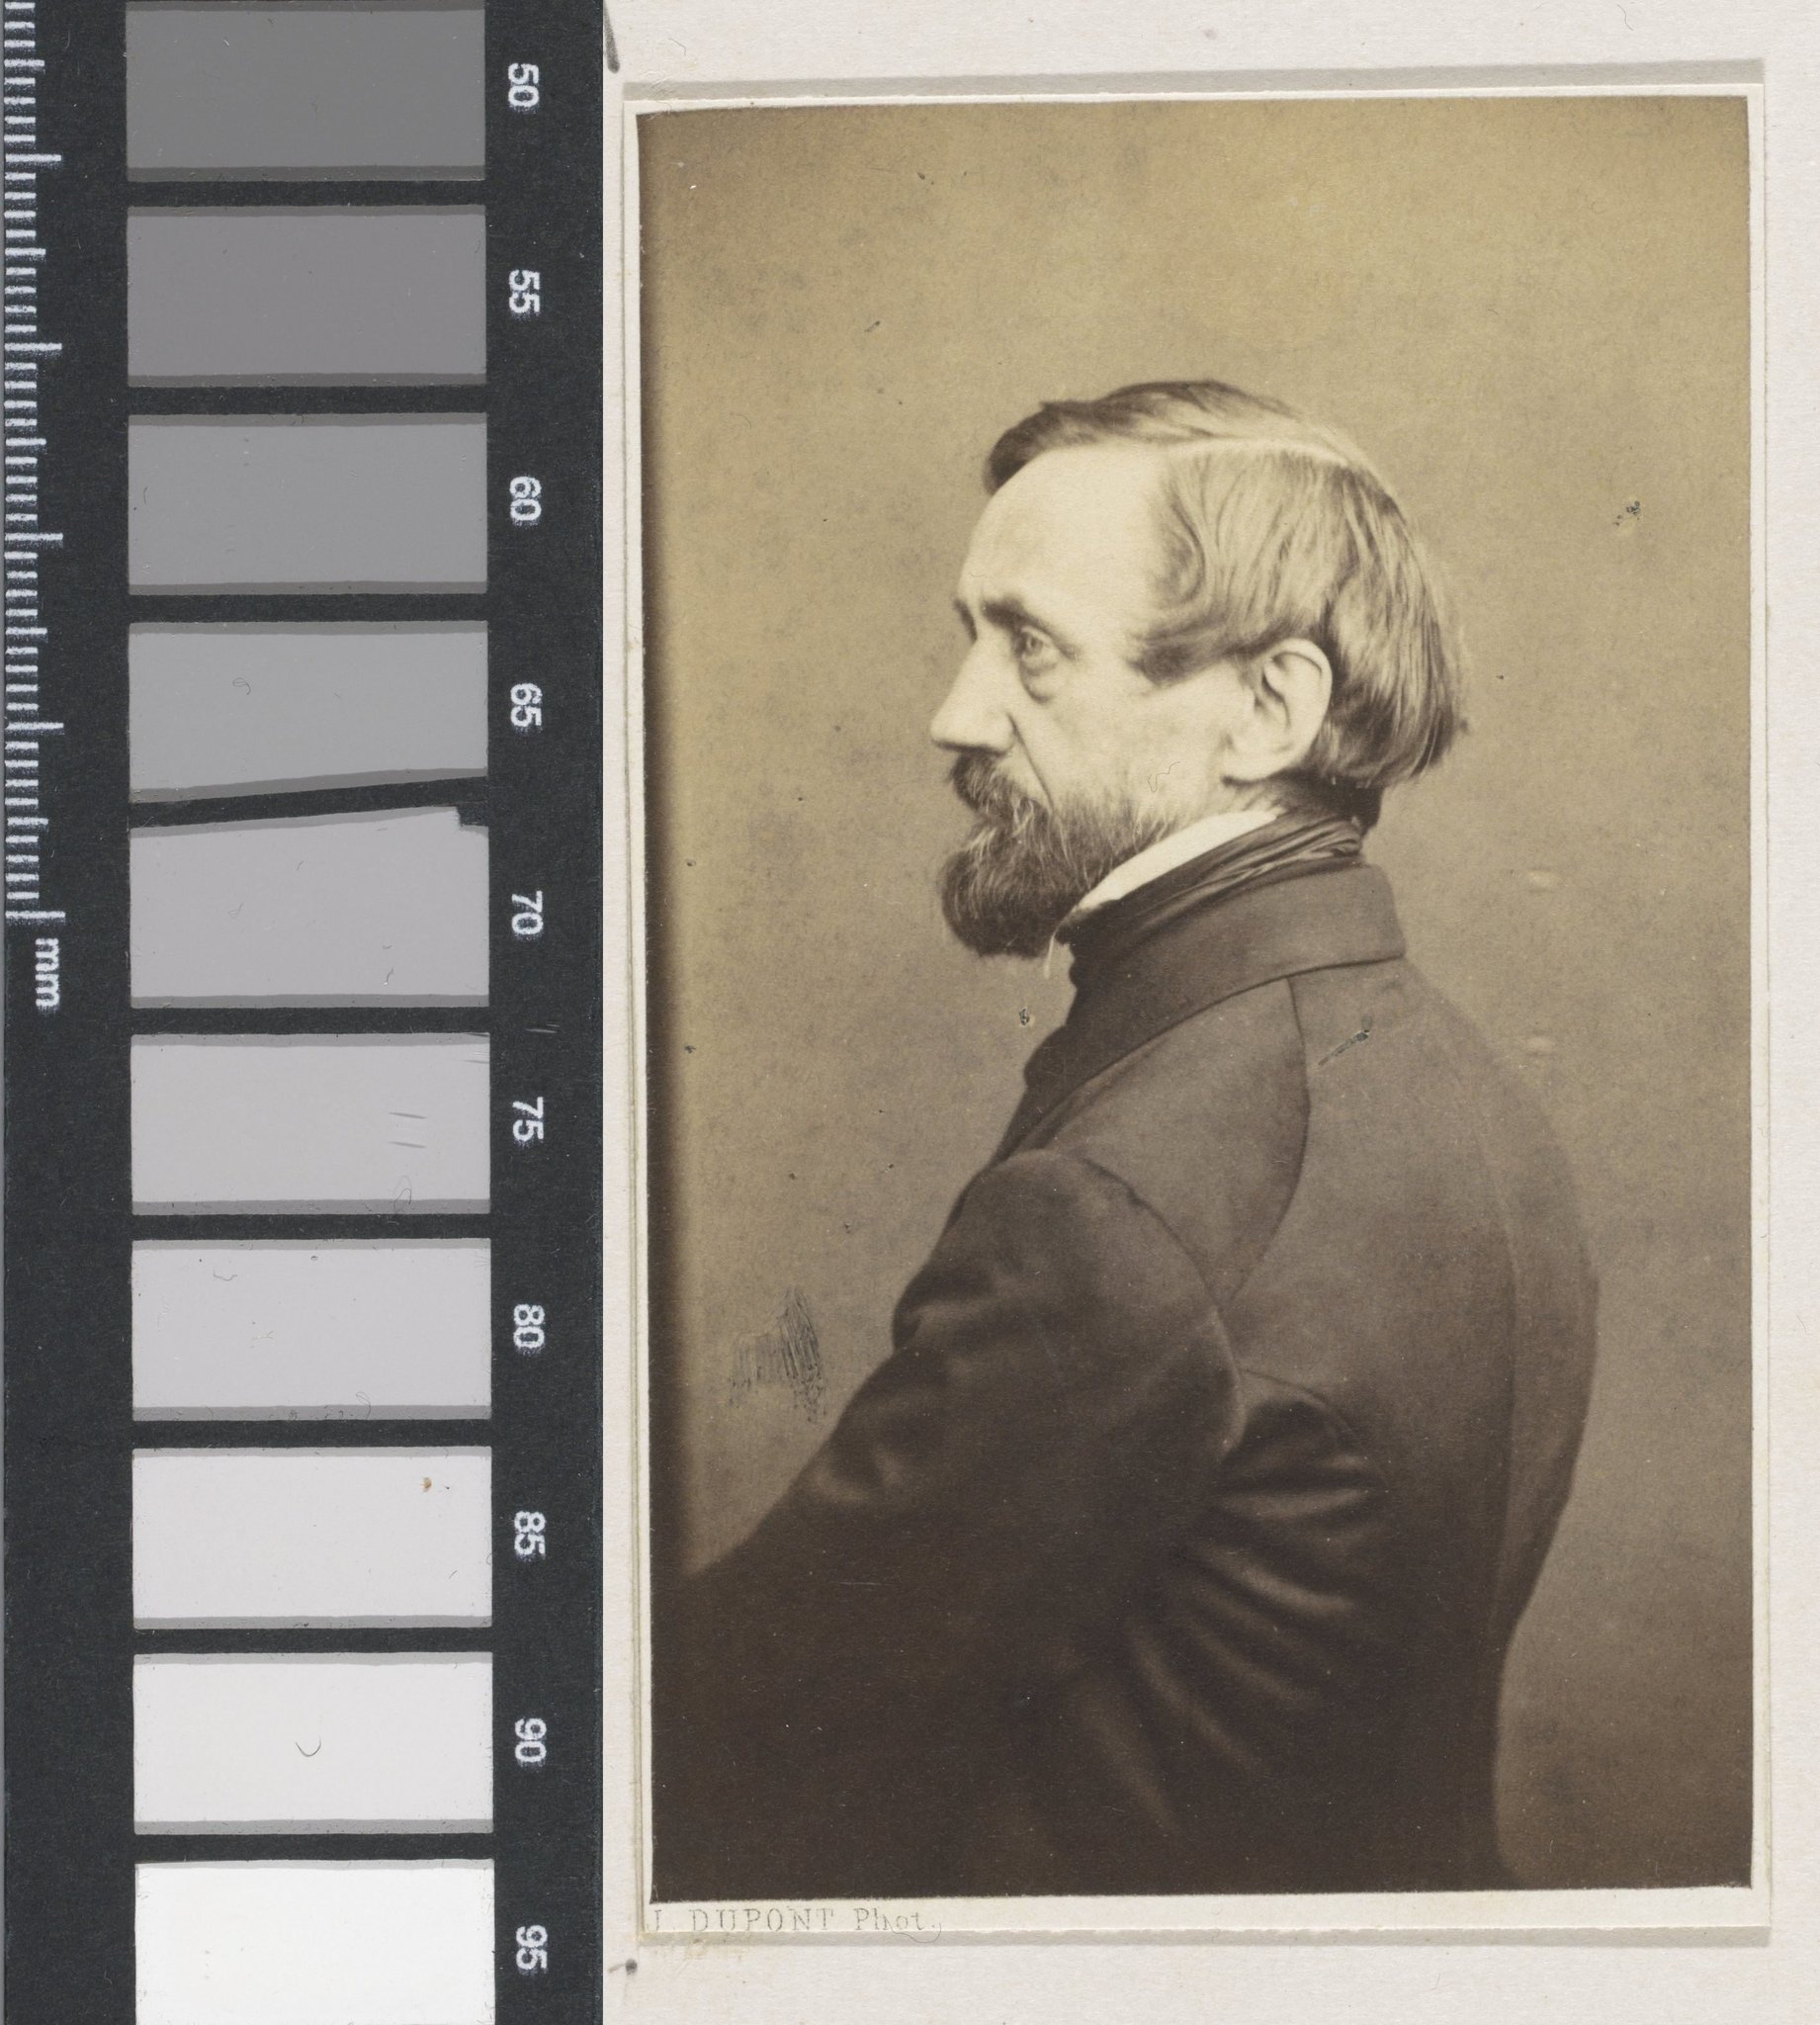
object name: carte de visite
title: L'École d'Anvers. Portraits biographies cartes de visite. Collection Dupont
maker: joseph dupont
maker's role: fotograaf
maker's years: 1818-1901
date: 1861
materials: cardboard, paper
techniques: albumen print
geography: antwerp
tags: antwerp, jean antoine verschaeren, historical persons, portrait, self-portrait of painter, portrait, self-portrait of artist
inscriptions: inscription: ‘ETABLISSEMENT PHOTOGRAPHIQUE/ de/ J. DUPONT/ Place de Meir 32/ ANVERS/ Maison fondée en 1853’, inscription: ‘Verschaeren’